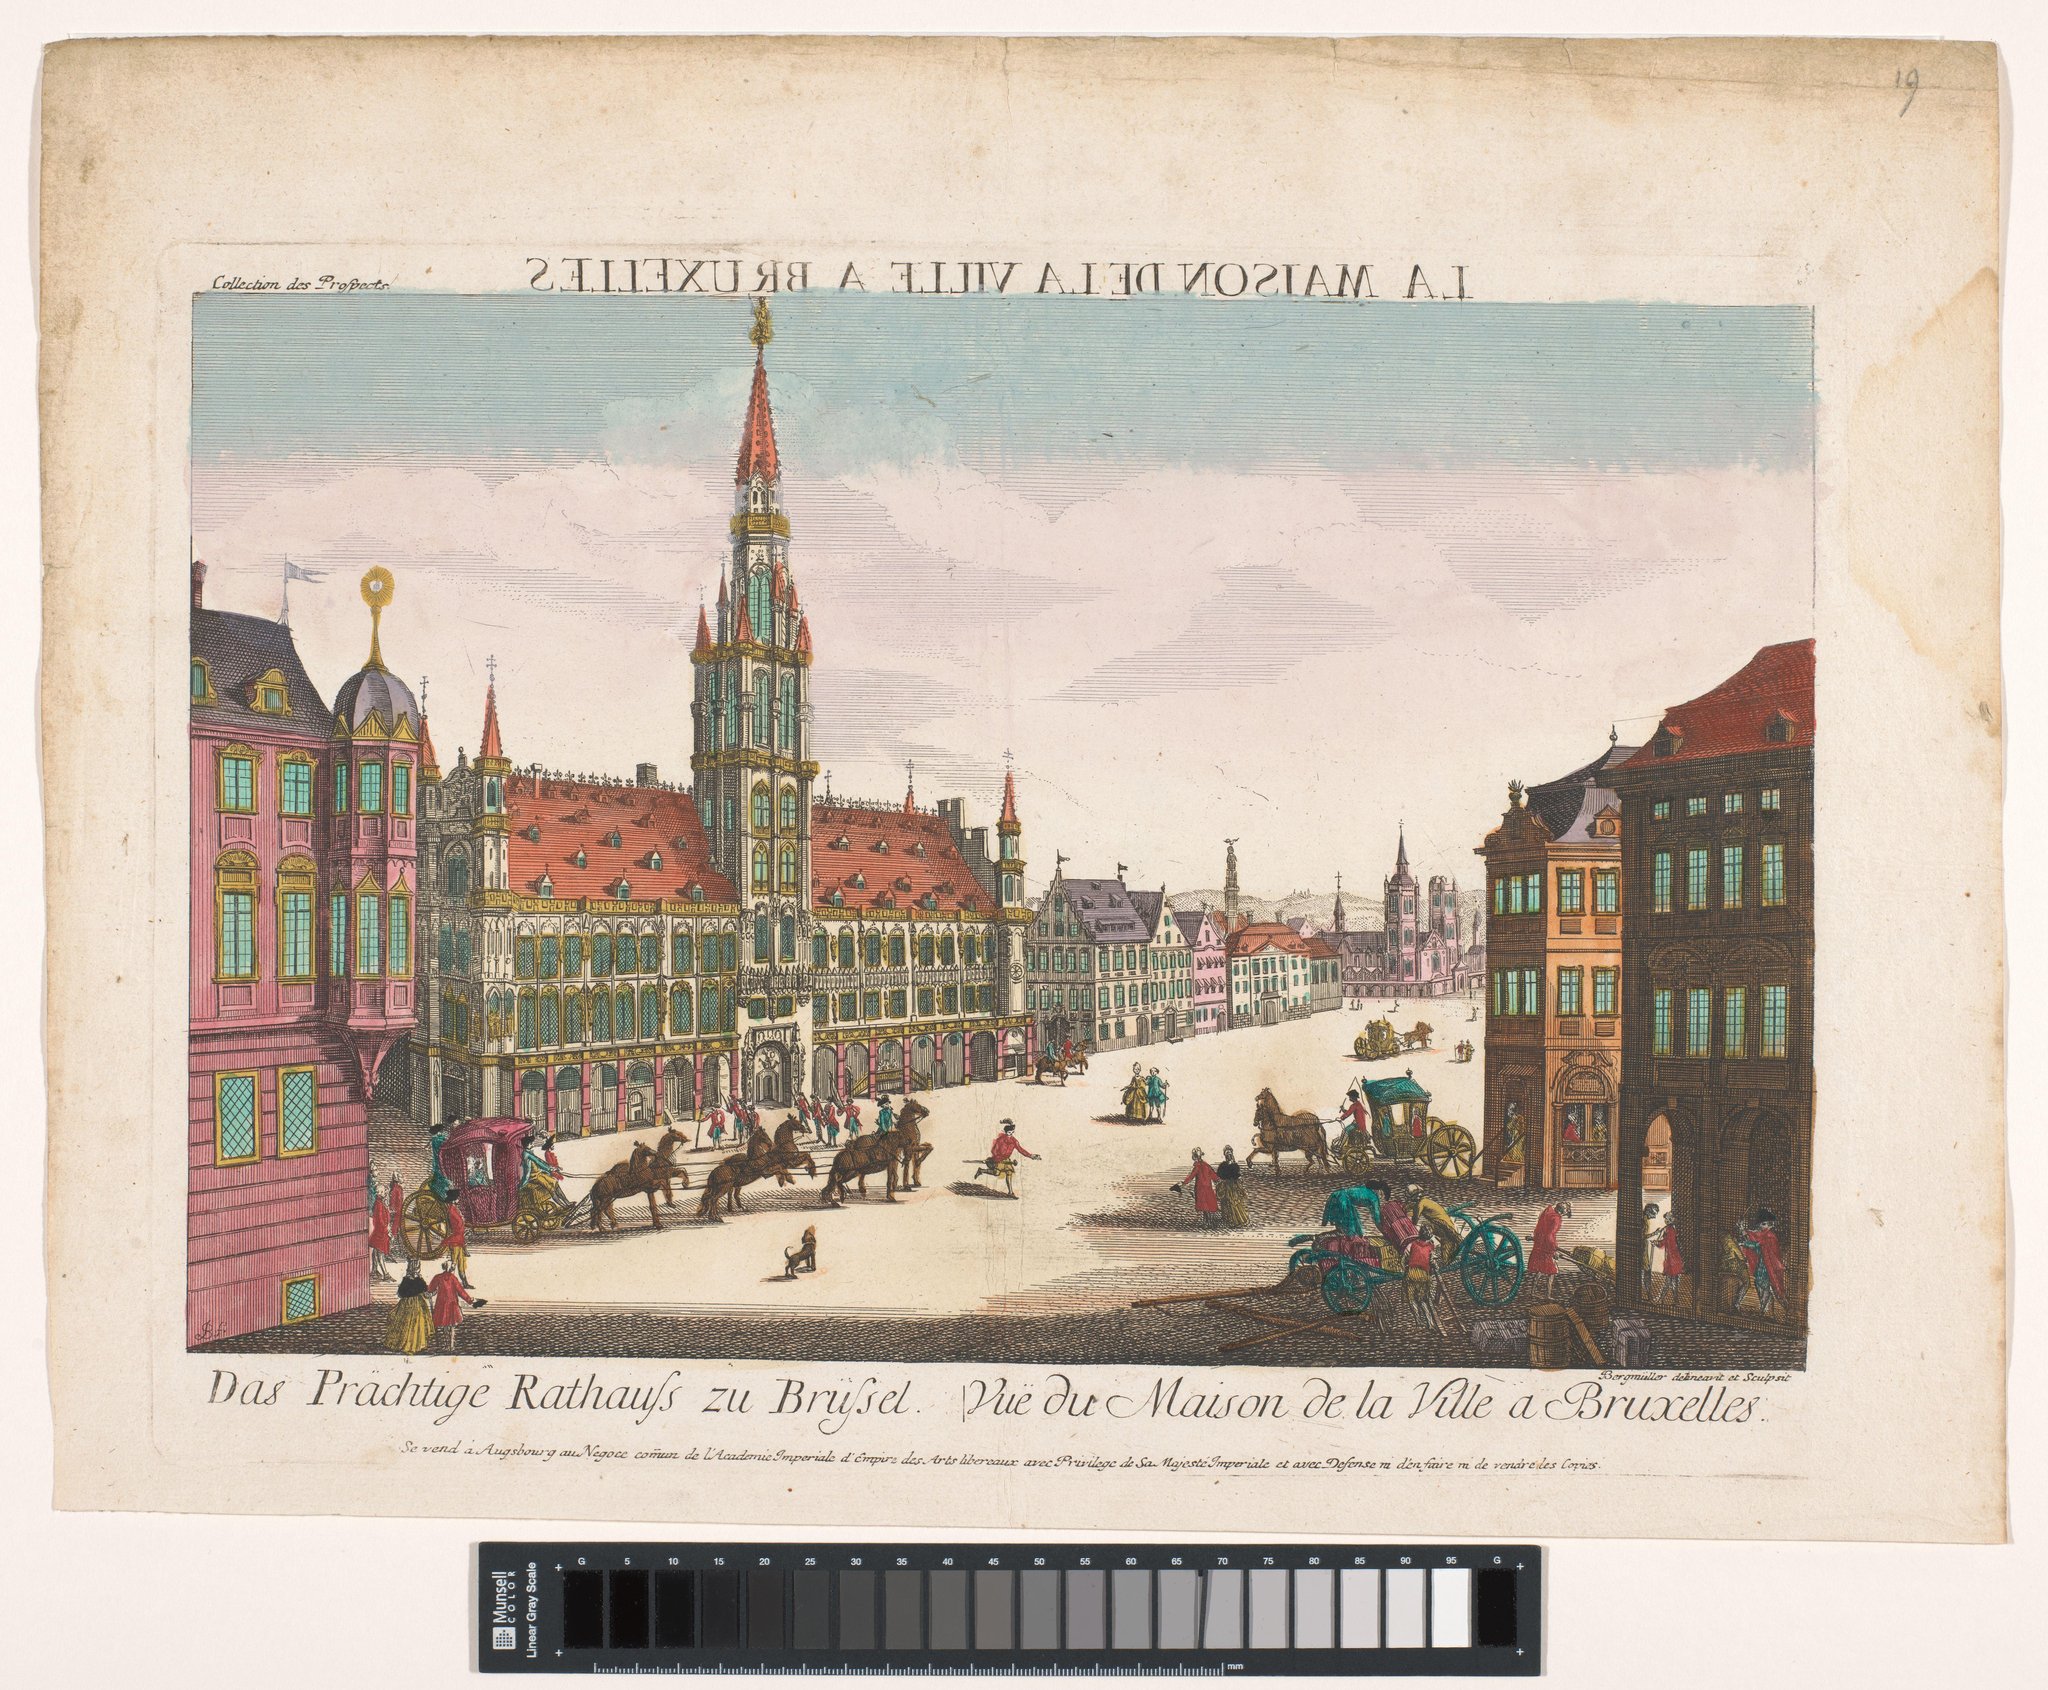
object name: opticaprent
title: Gezicht op het Stadhuis aan de Grote Markt te Brussel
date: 1755-1779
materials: paper, watercolor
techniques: brush, etching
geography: germany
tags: townhall, square, place, circus, etc. (+ city(-scape) with figures, staffage), street (+ city(-scape) with figures, staffage)